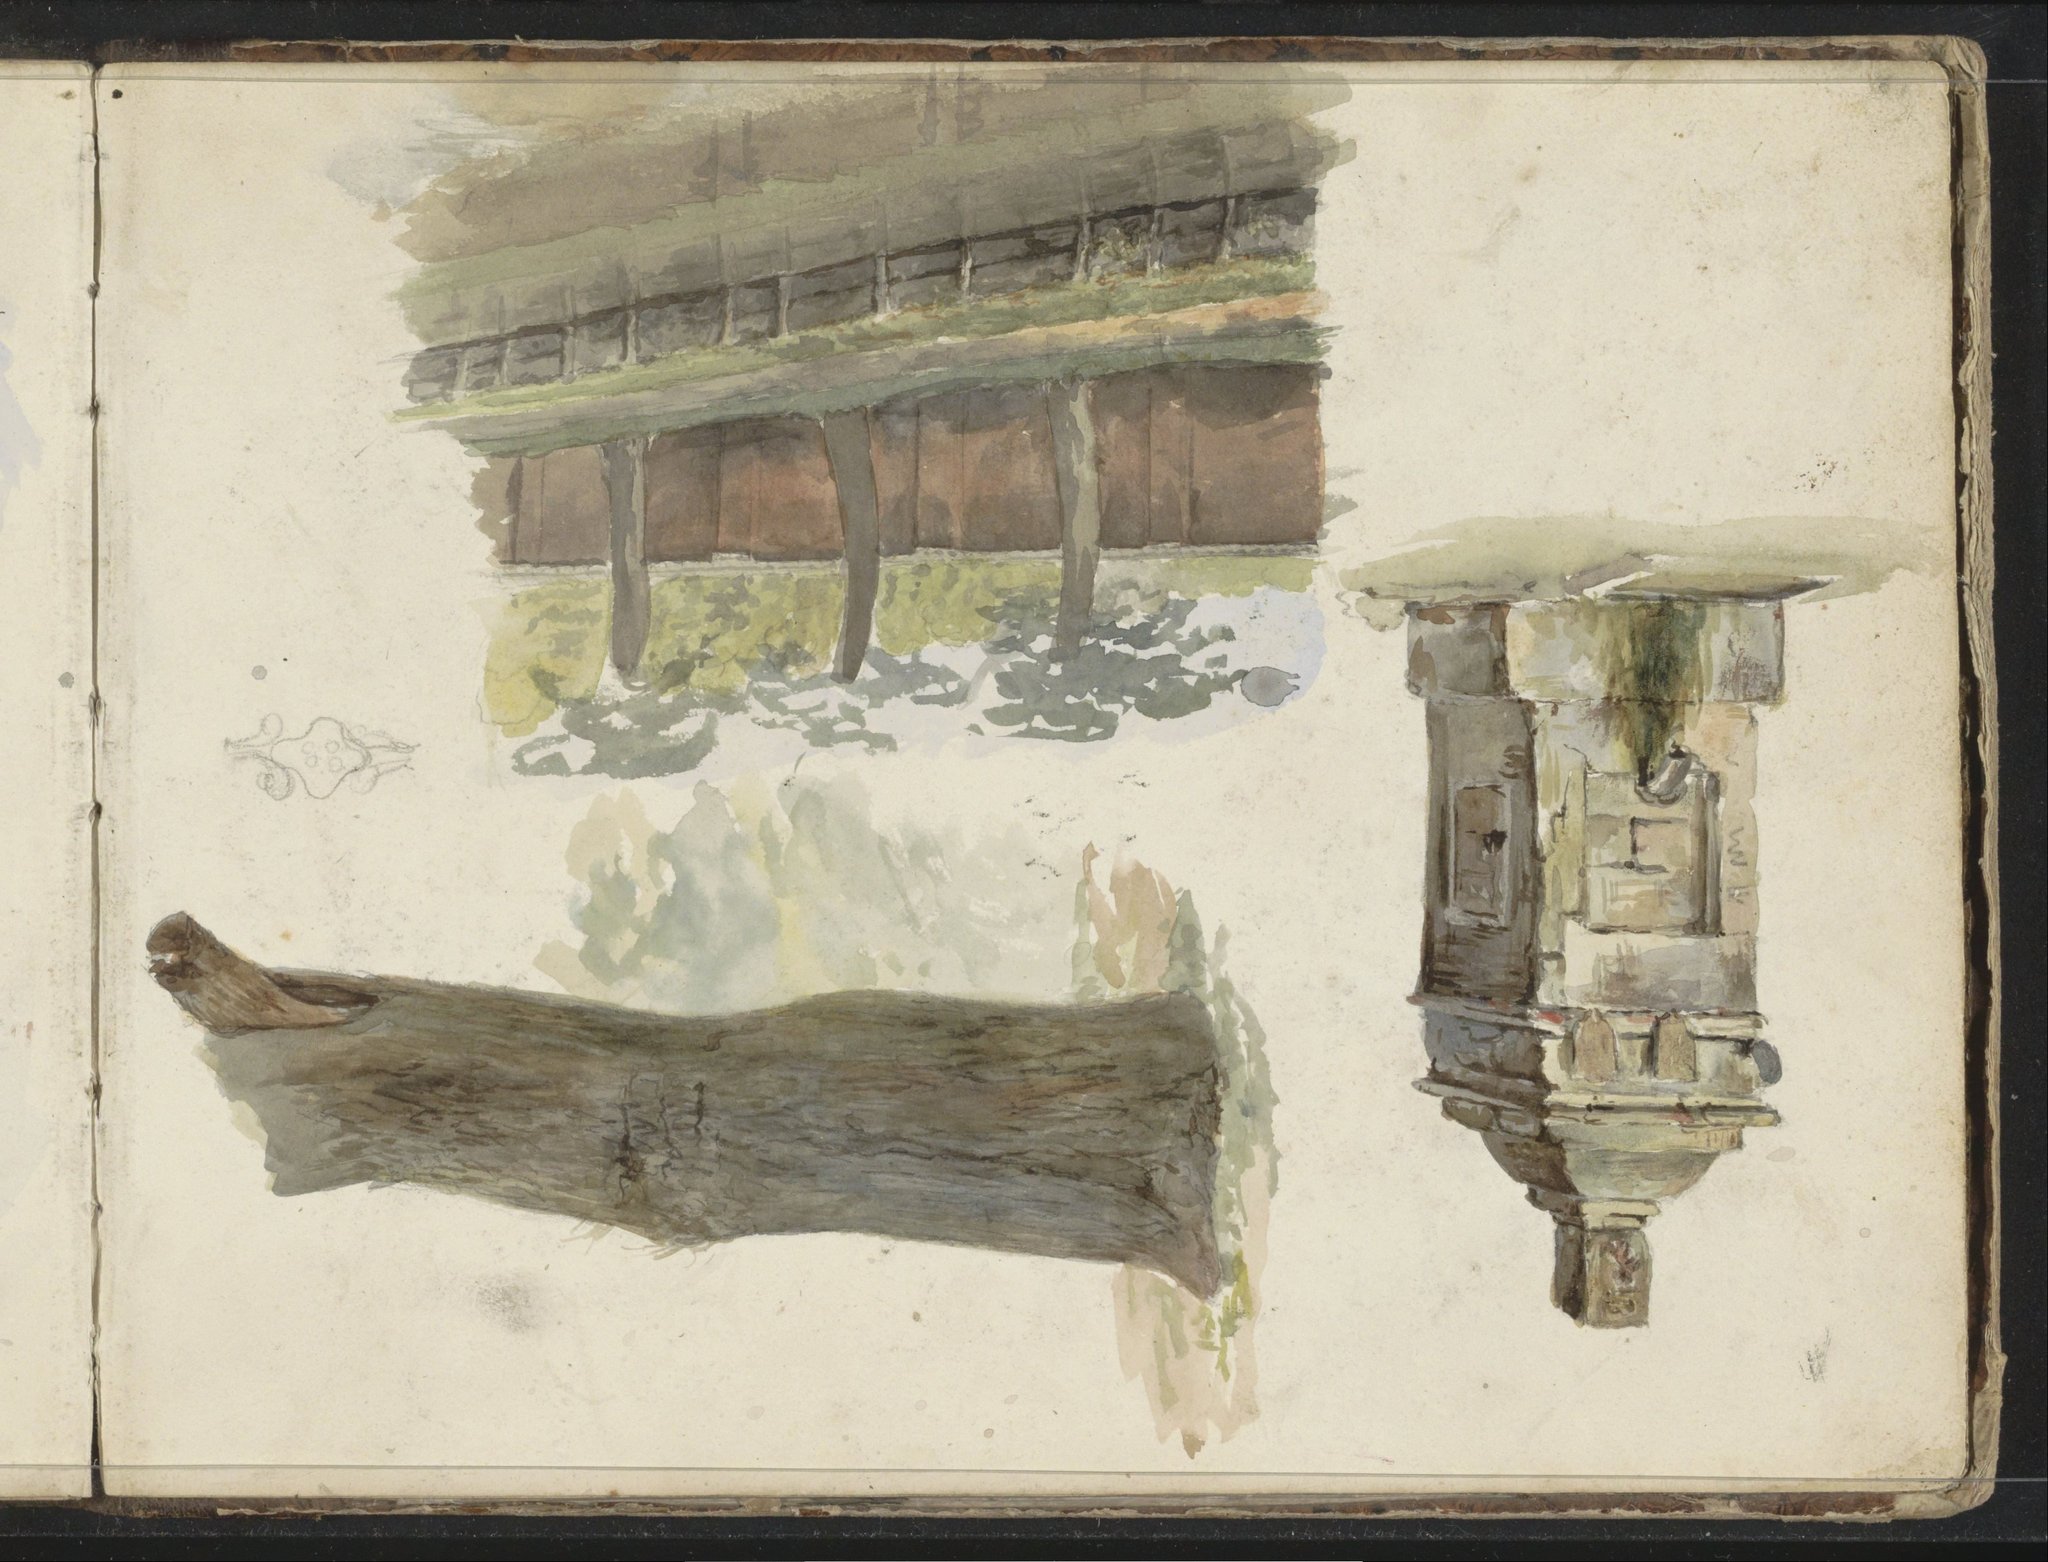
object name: sketchbook leaf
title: Bomen langs een kanaal en een stenen gebouw met waterkraan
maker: willem troost (ii)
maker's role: draughtsman, painter, print maker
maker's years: 1812-1893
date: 1822-1893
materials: paper, pencil, watercolor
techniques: brush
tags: tap, faucet (+ variant), canal, trees (+ stem, trunk)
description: Tevens een studie van een boomstam en ornament. Blad 61 recto uit een schetsboek met 36 bladen.